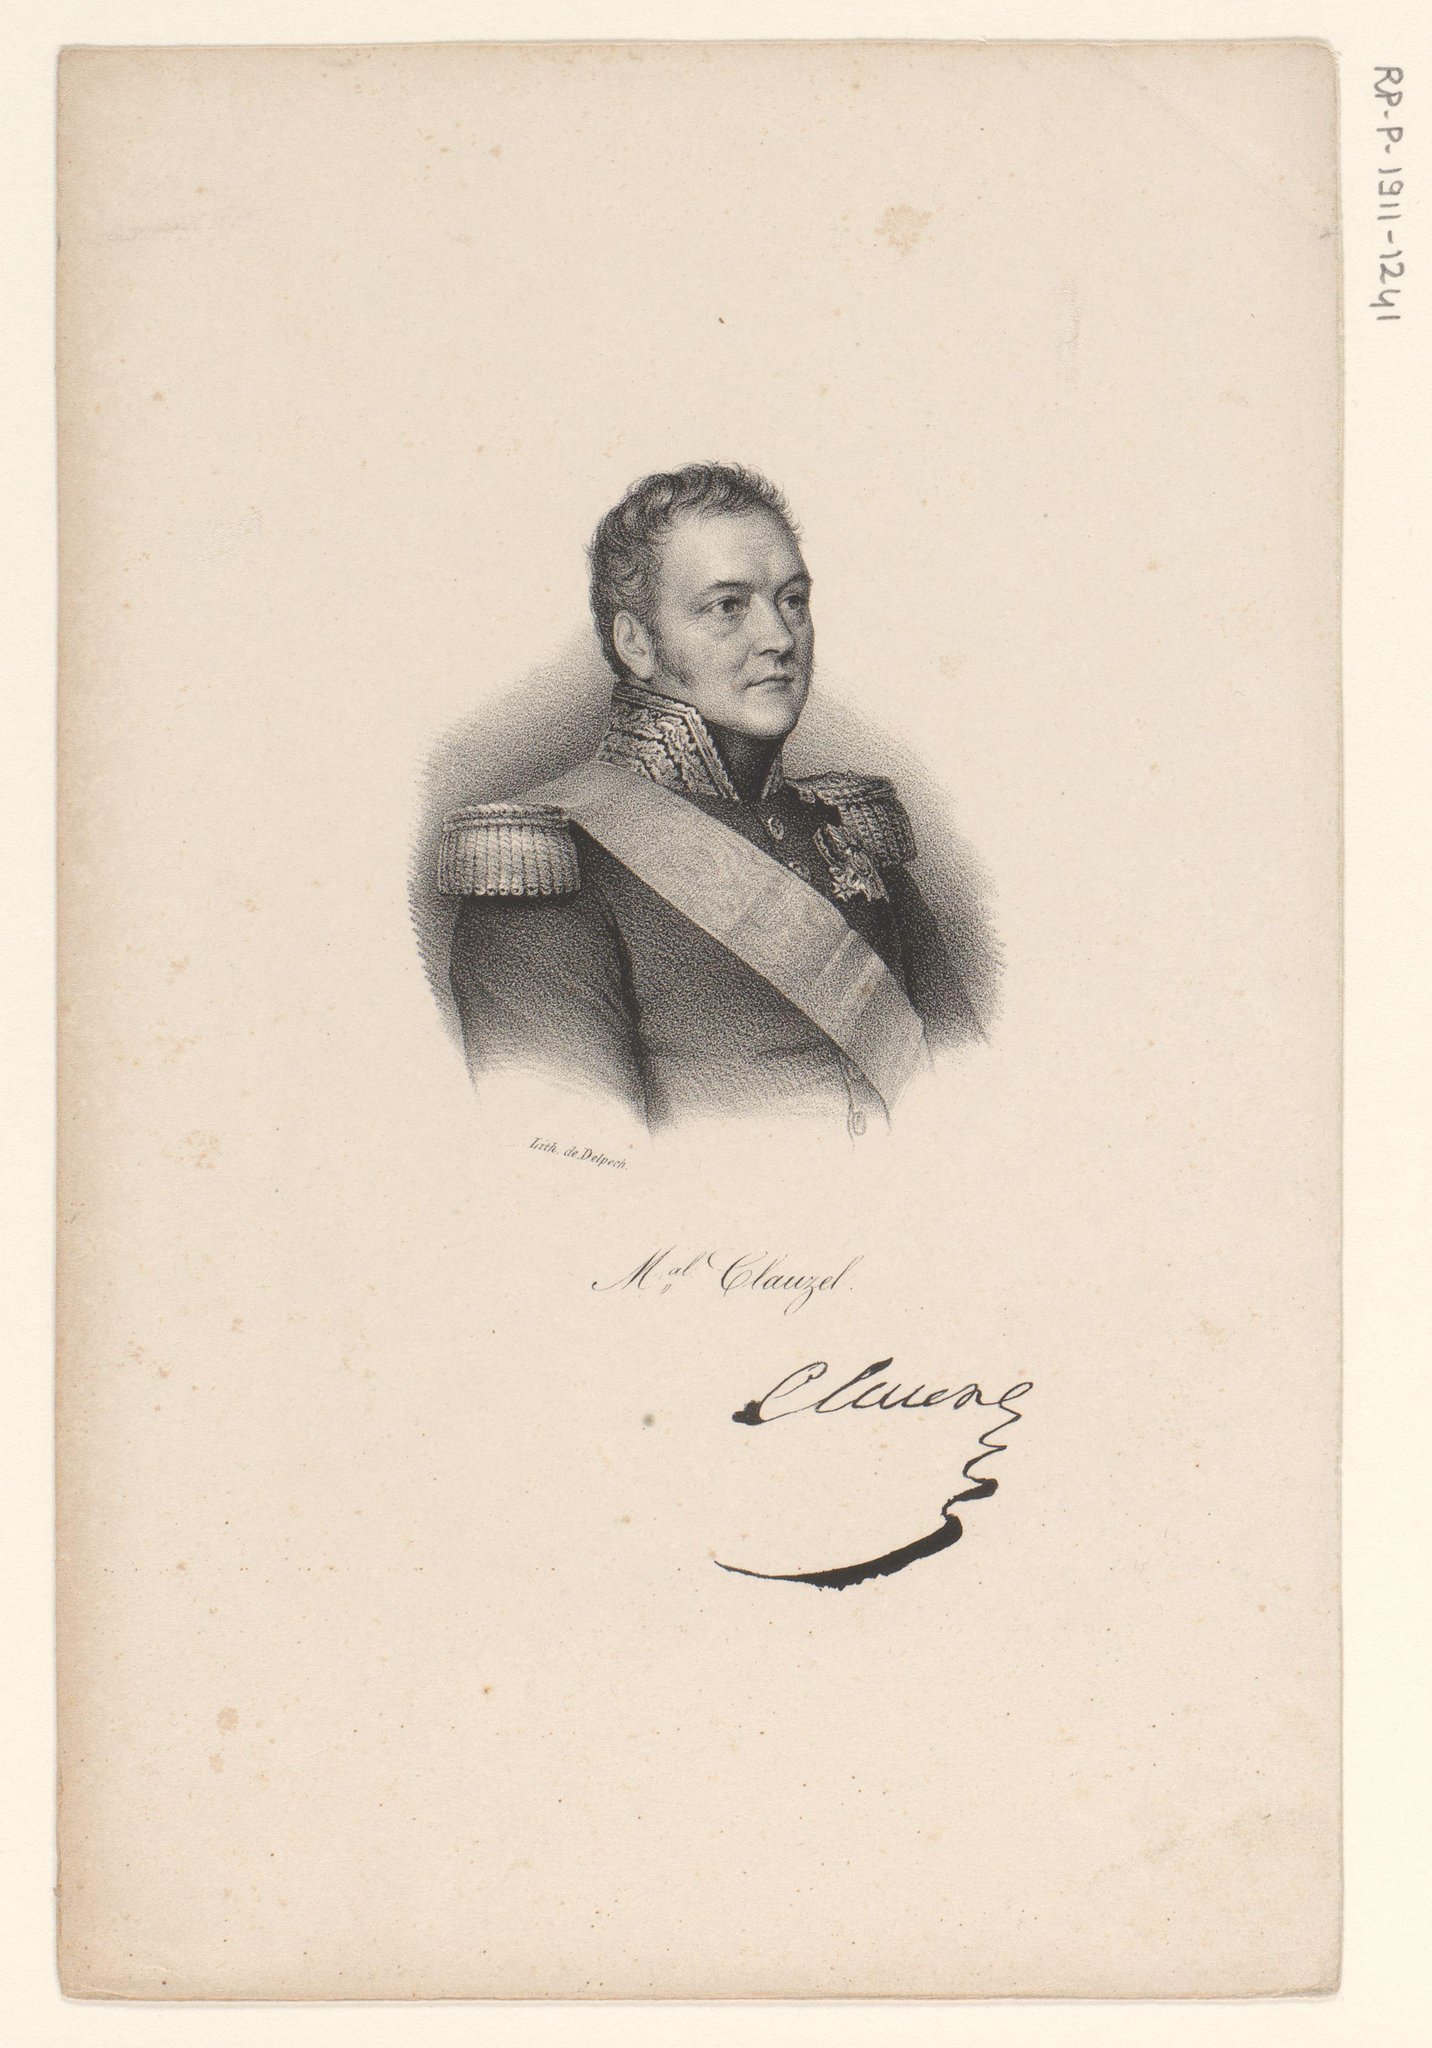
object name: print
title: Portret van Bertrand Clauzel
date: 1818-1842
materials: paper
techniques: lithograph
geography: paris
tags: historical persons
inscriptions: collector's mark: Lugt 2228a